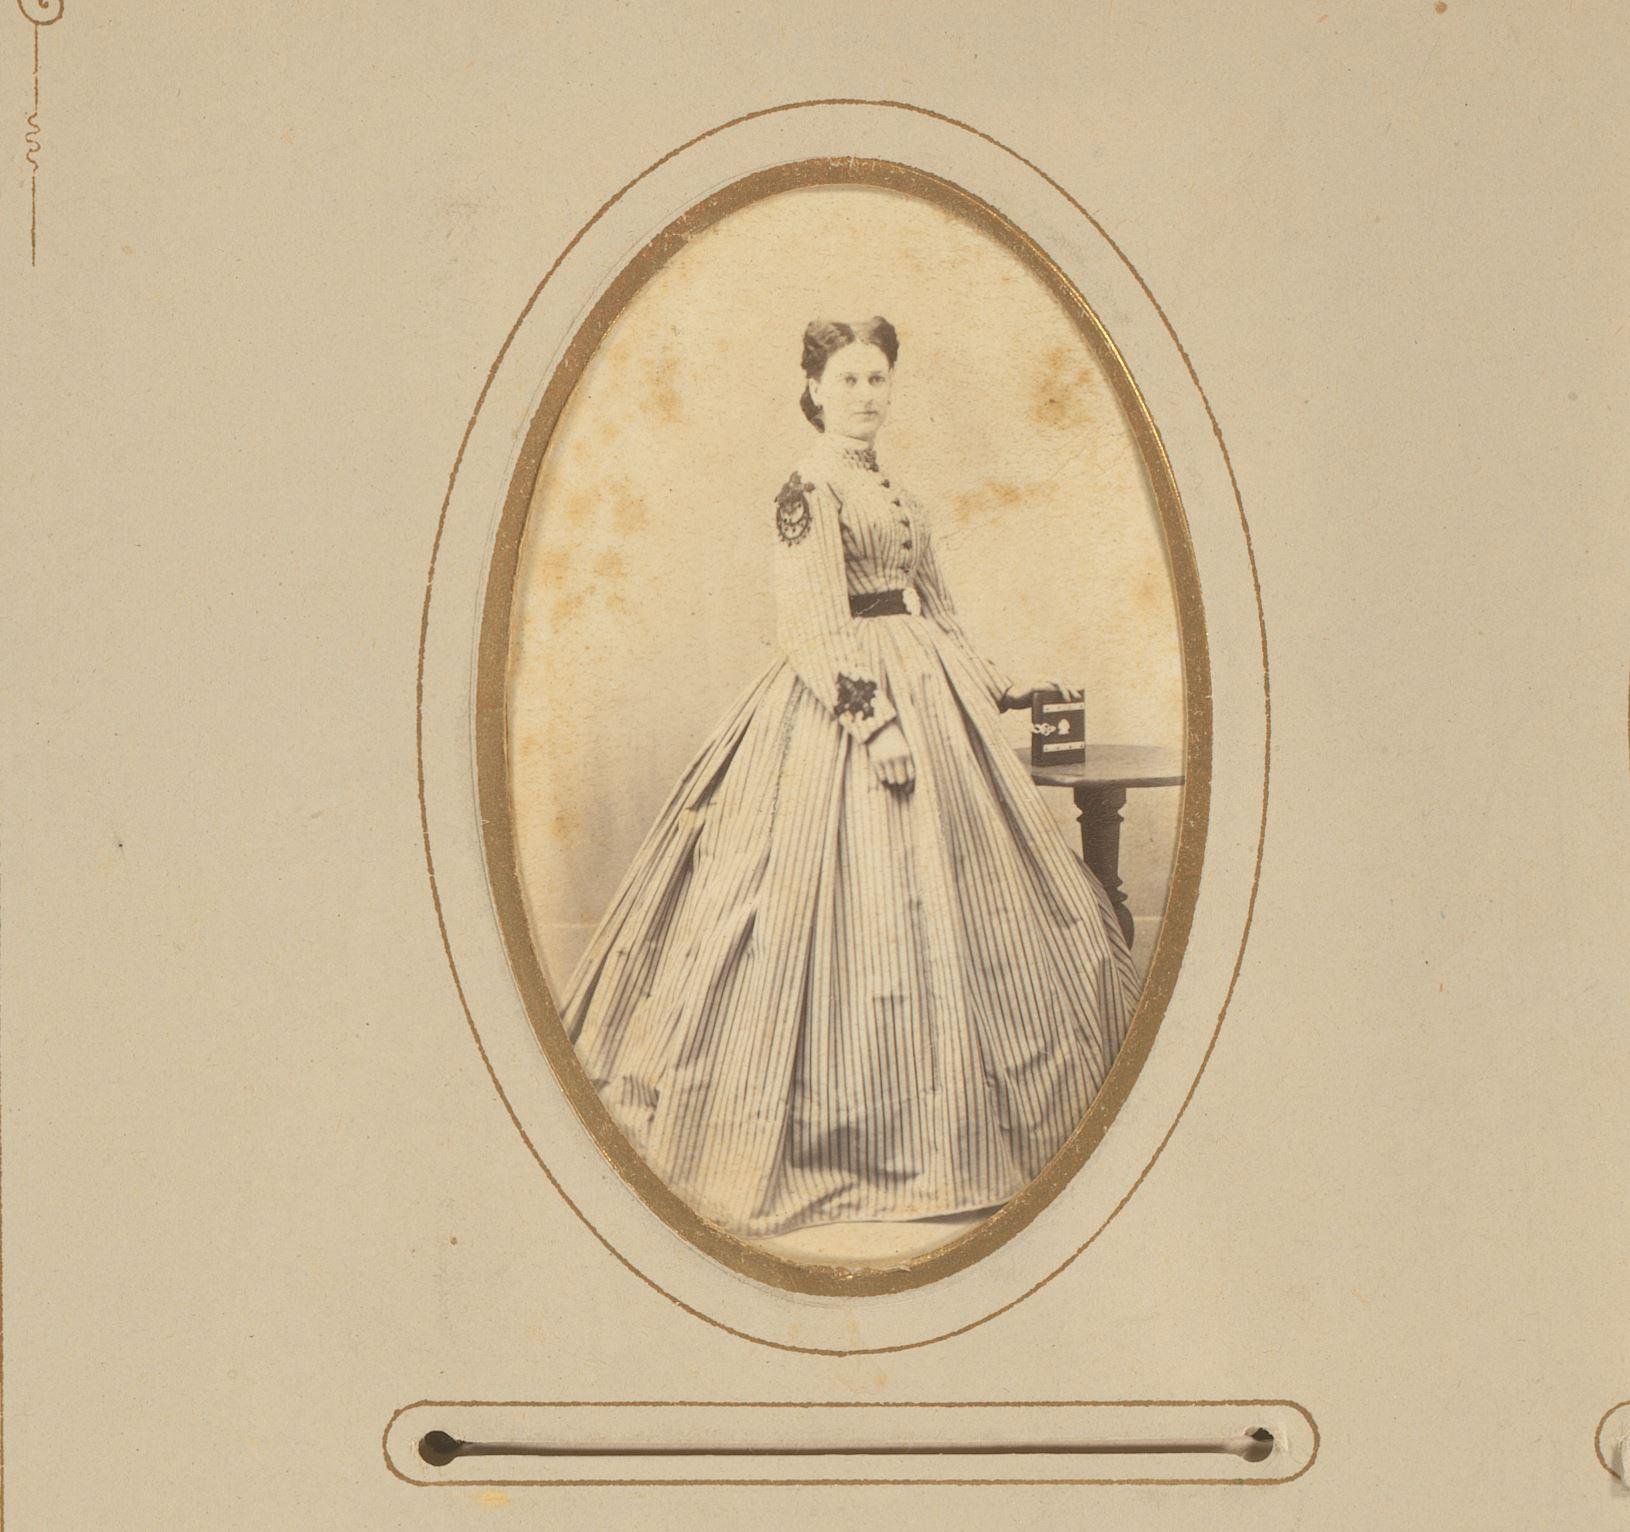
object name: photograph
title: Portret van een staande vrouw met een hand op een boek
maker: j. remde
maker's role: fotograaf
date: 1850-1880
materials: cardboard, photographic support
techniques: albumen print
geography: eisenach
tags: historical persons - bb - woman, book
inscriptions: inscription: ‘J. Remde/ Photogr. Atelier/ Eisenach.’